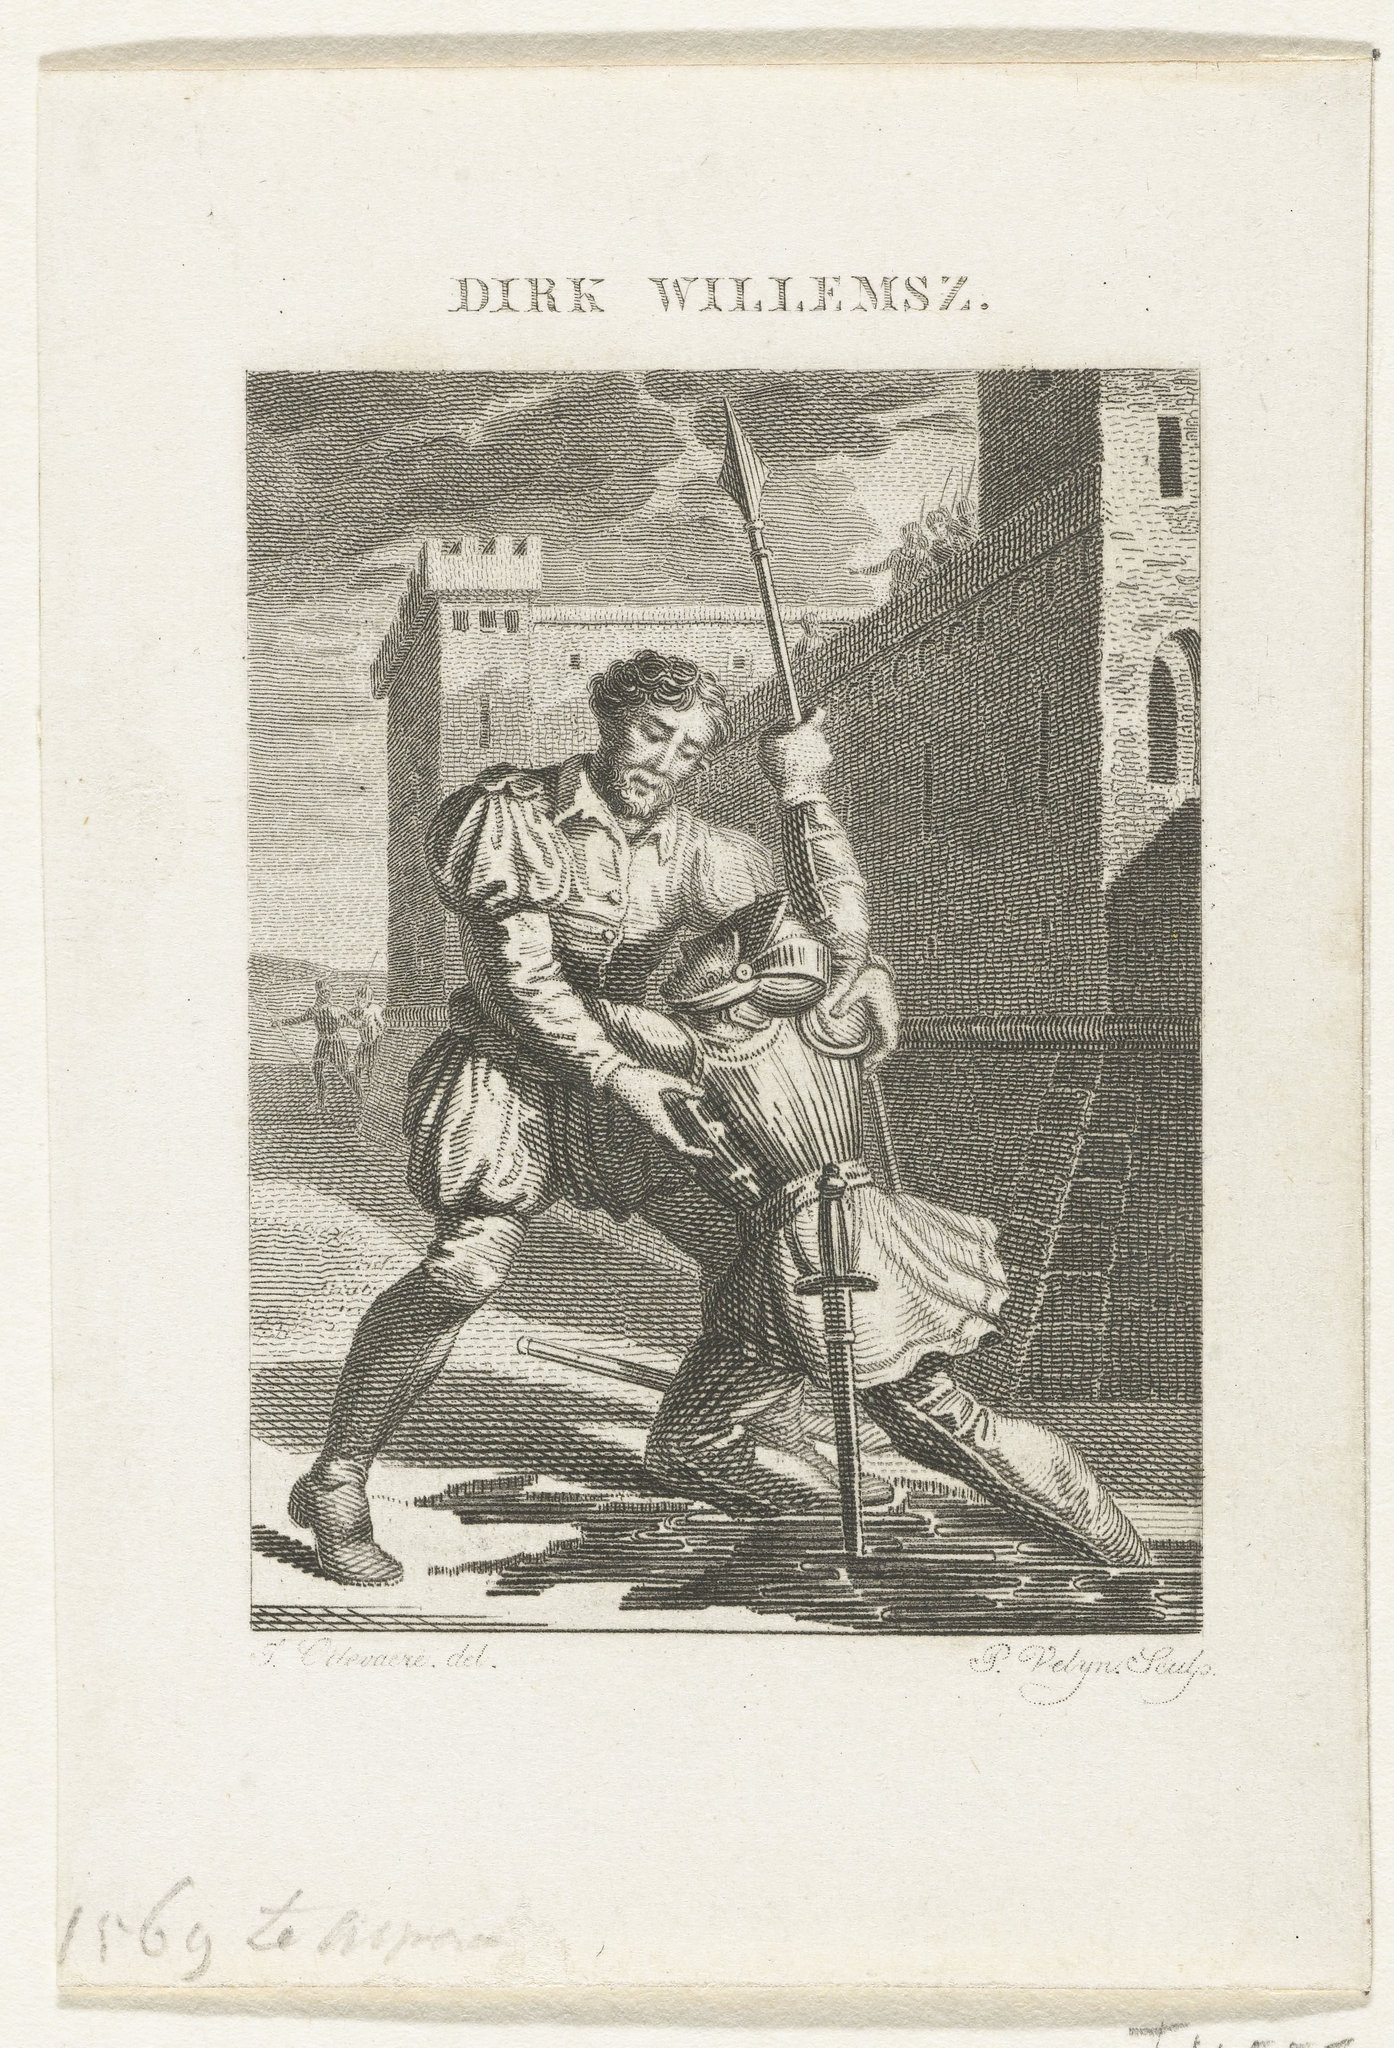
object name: history print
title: Dirk Willemsz. redt zijn vervolger uit het ijs bij Asperen, 1569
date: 1817-1819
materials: paper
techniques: etching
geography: netherlands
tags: asperen, persecution of heretics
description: Dirk Willemsz. redt zijn vervolger, een geharnaste Spaanse soldaat, uit het ijs bij Asperen, 1569.